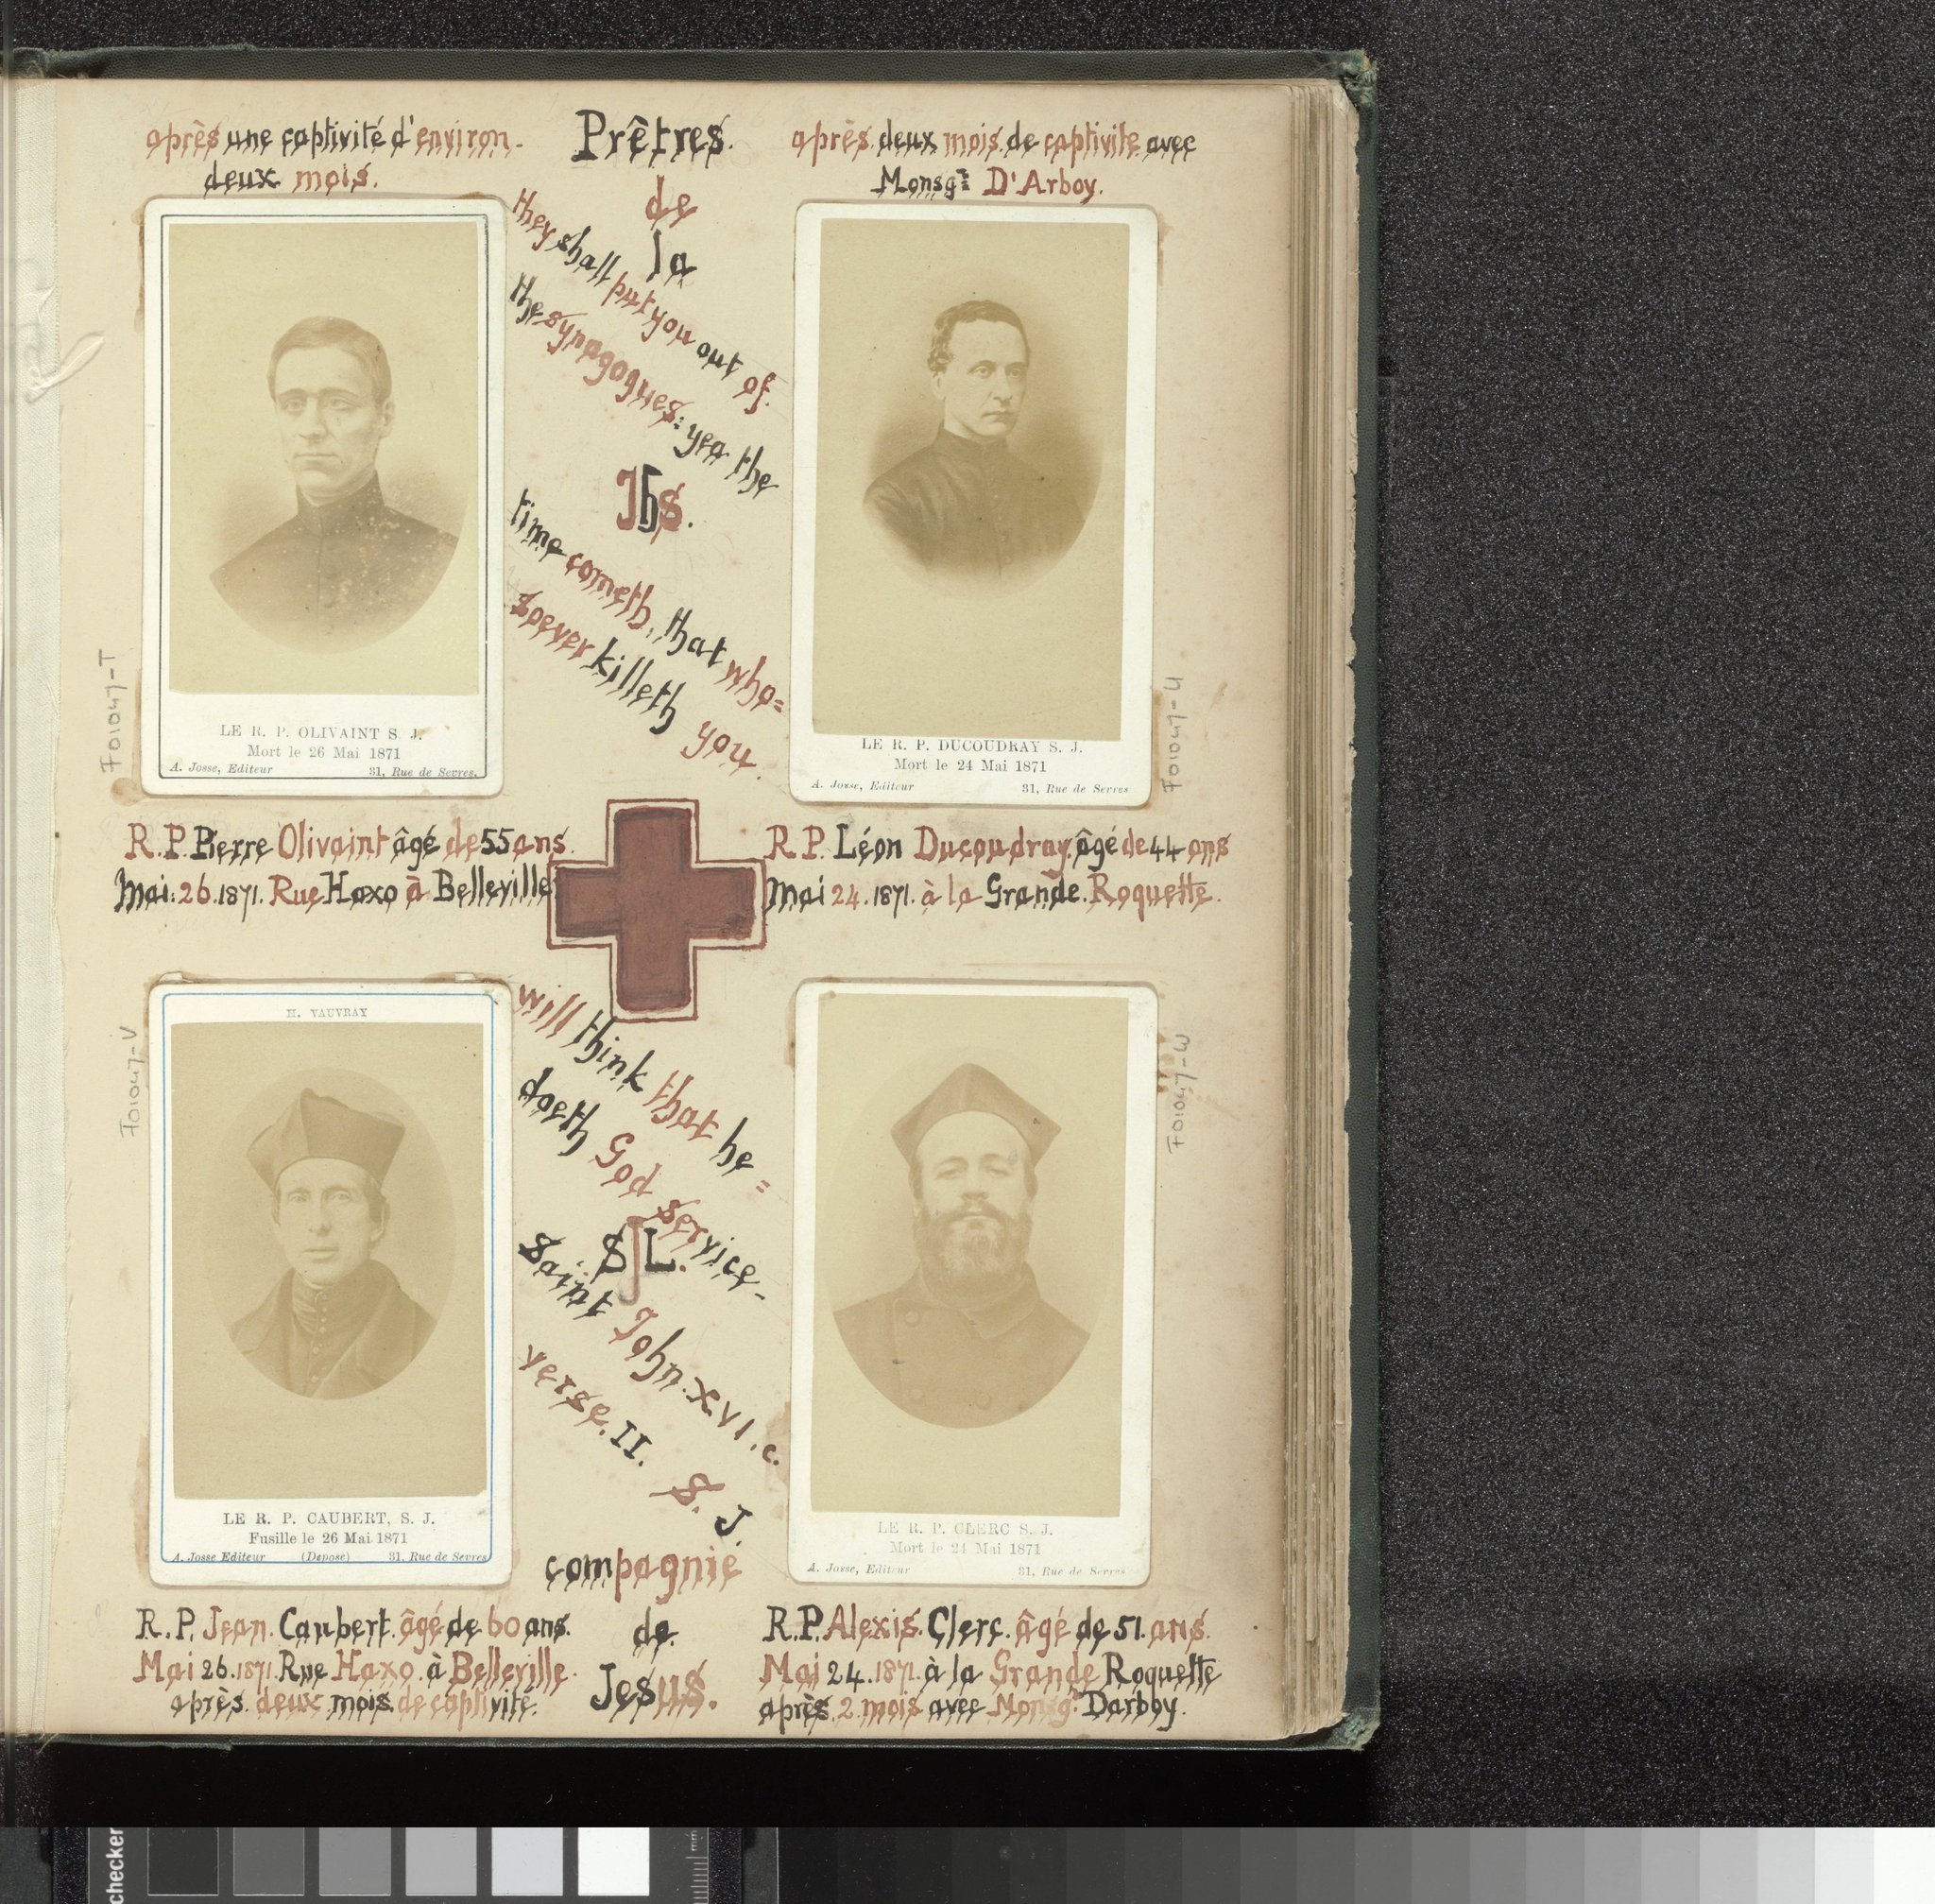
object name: album leaf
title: Portret van R.P. Caubert, S.J.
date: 1871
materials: cardboard, paper, photographic support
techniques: albumen print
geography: paris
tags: priest (roman catholic)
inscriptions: address: ‘31, Rue de Sevres’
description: Onderdeel van Herdenkingsalbum van rooms-katholieke geestelijken gevallen tijdens de Commune van Parijs.